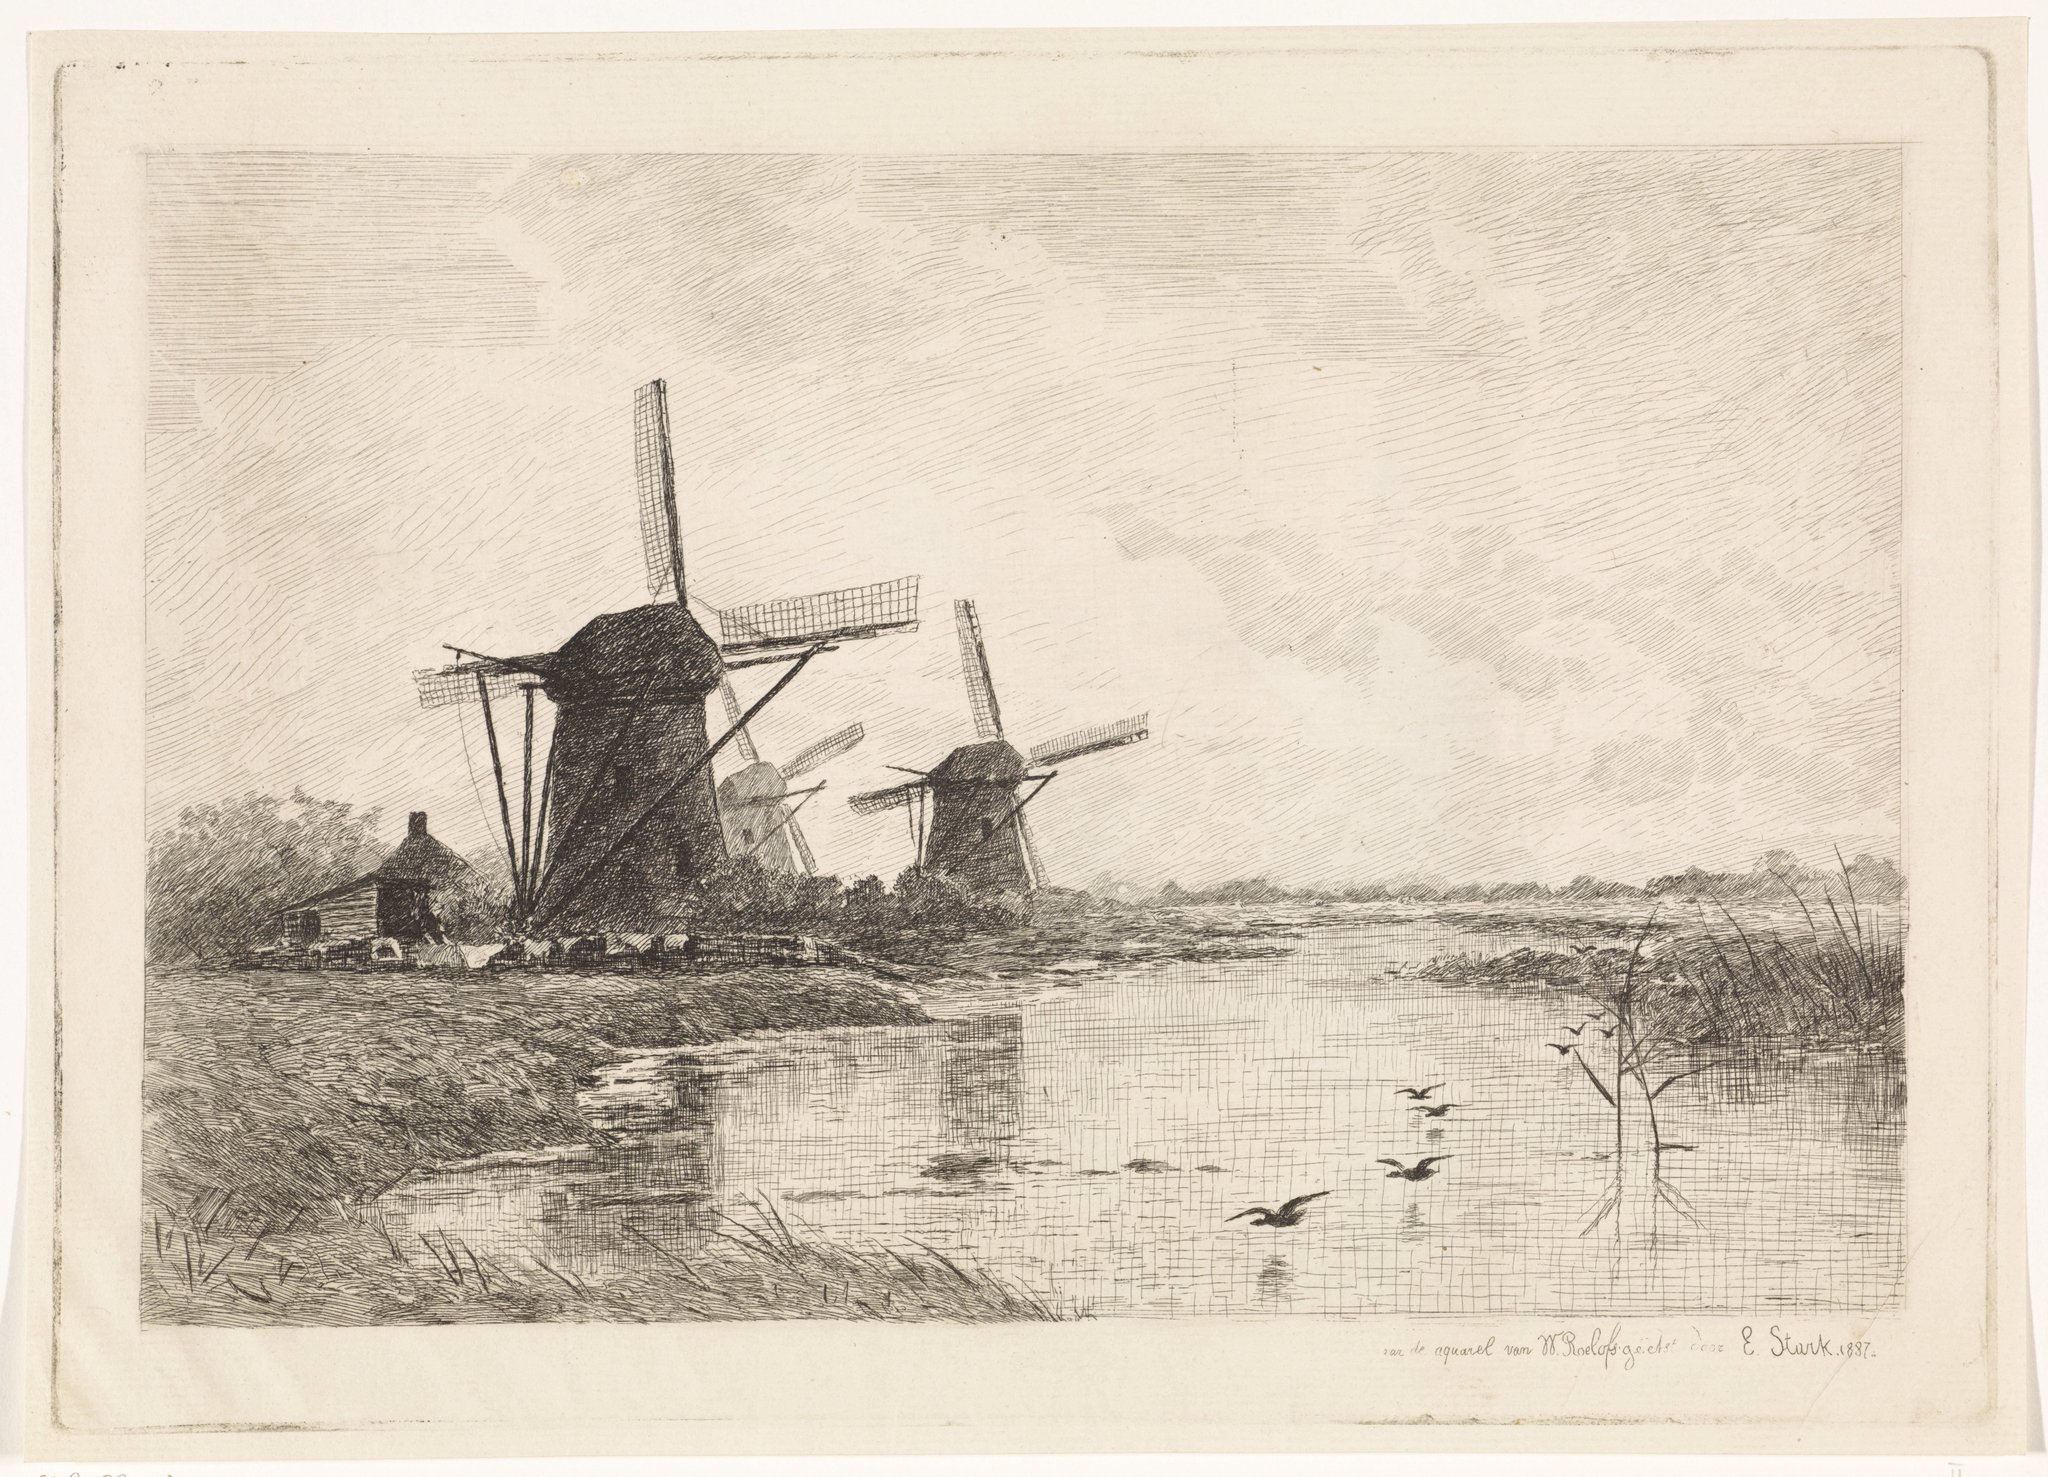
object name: print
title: Landschap met drie molens langs een vaart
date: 1887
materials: paper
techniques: etching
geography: nieuwer-amstel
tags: canal, windmill in landscape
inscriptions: collector's mark: Lugt 2228